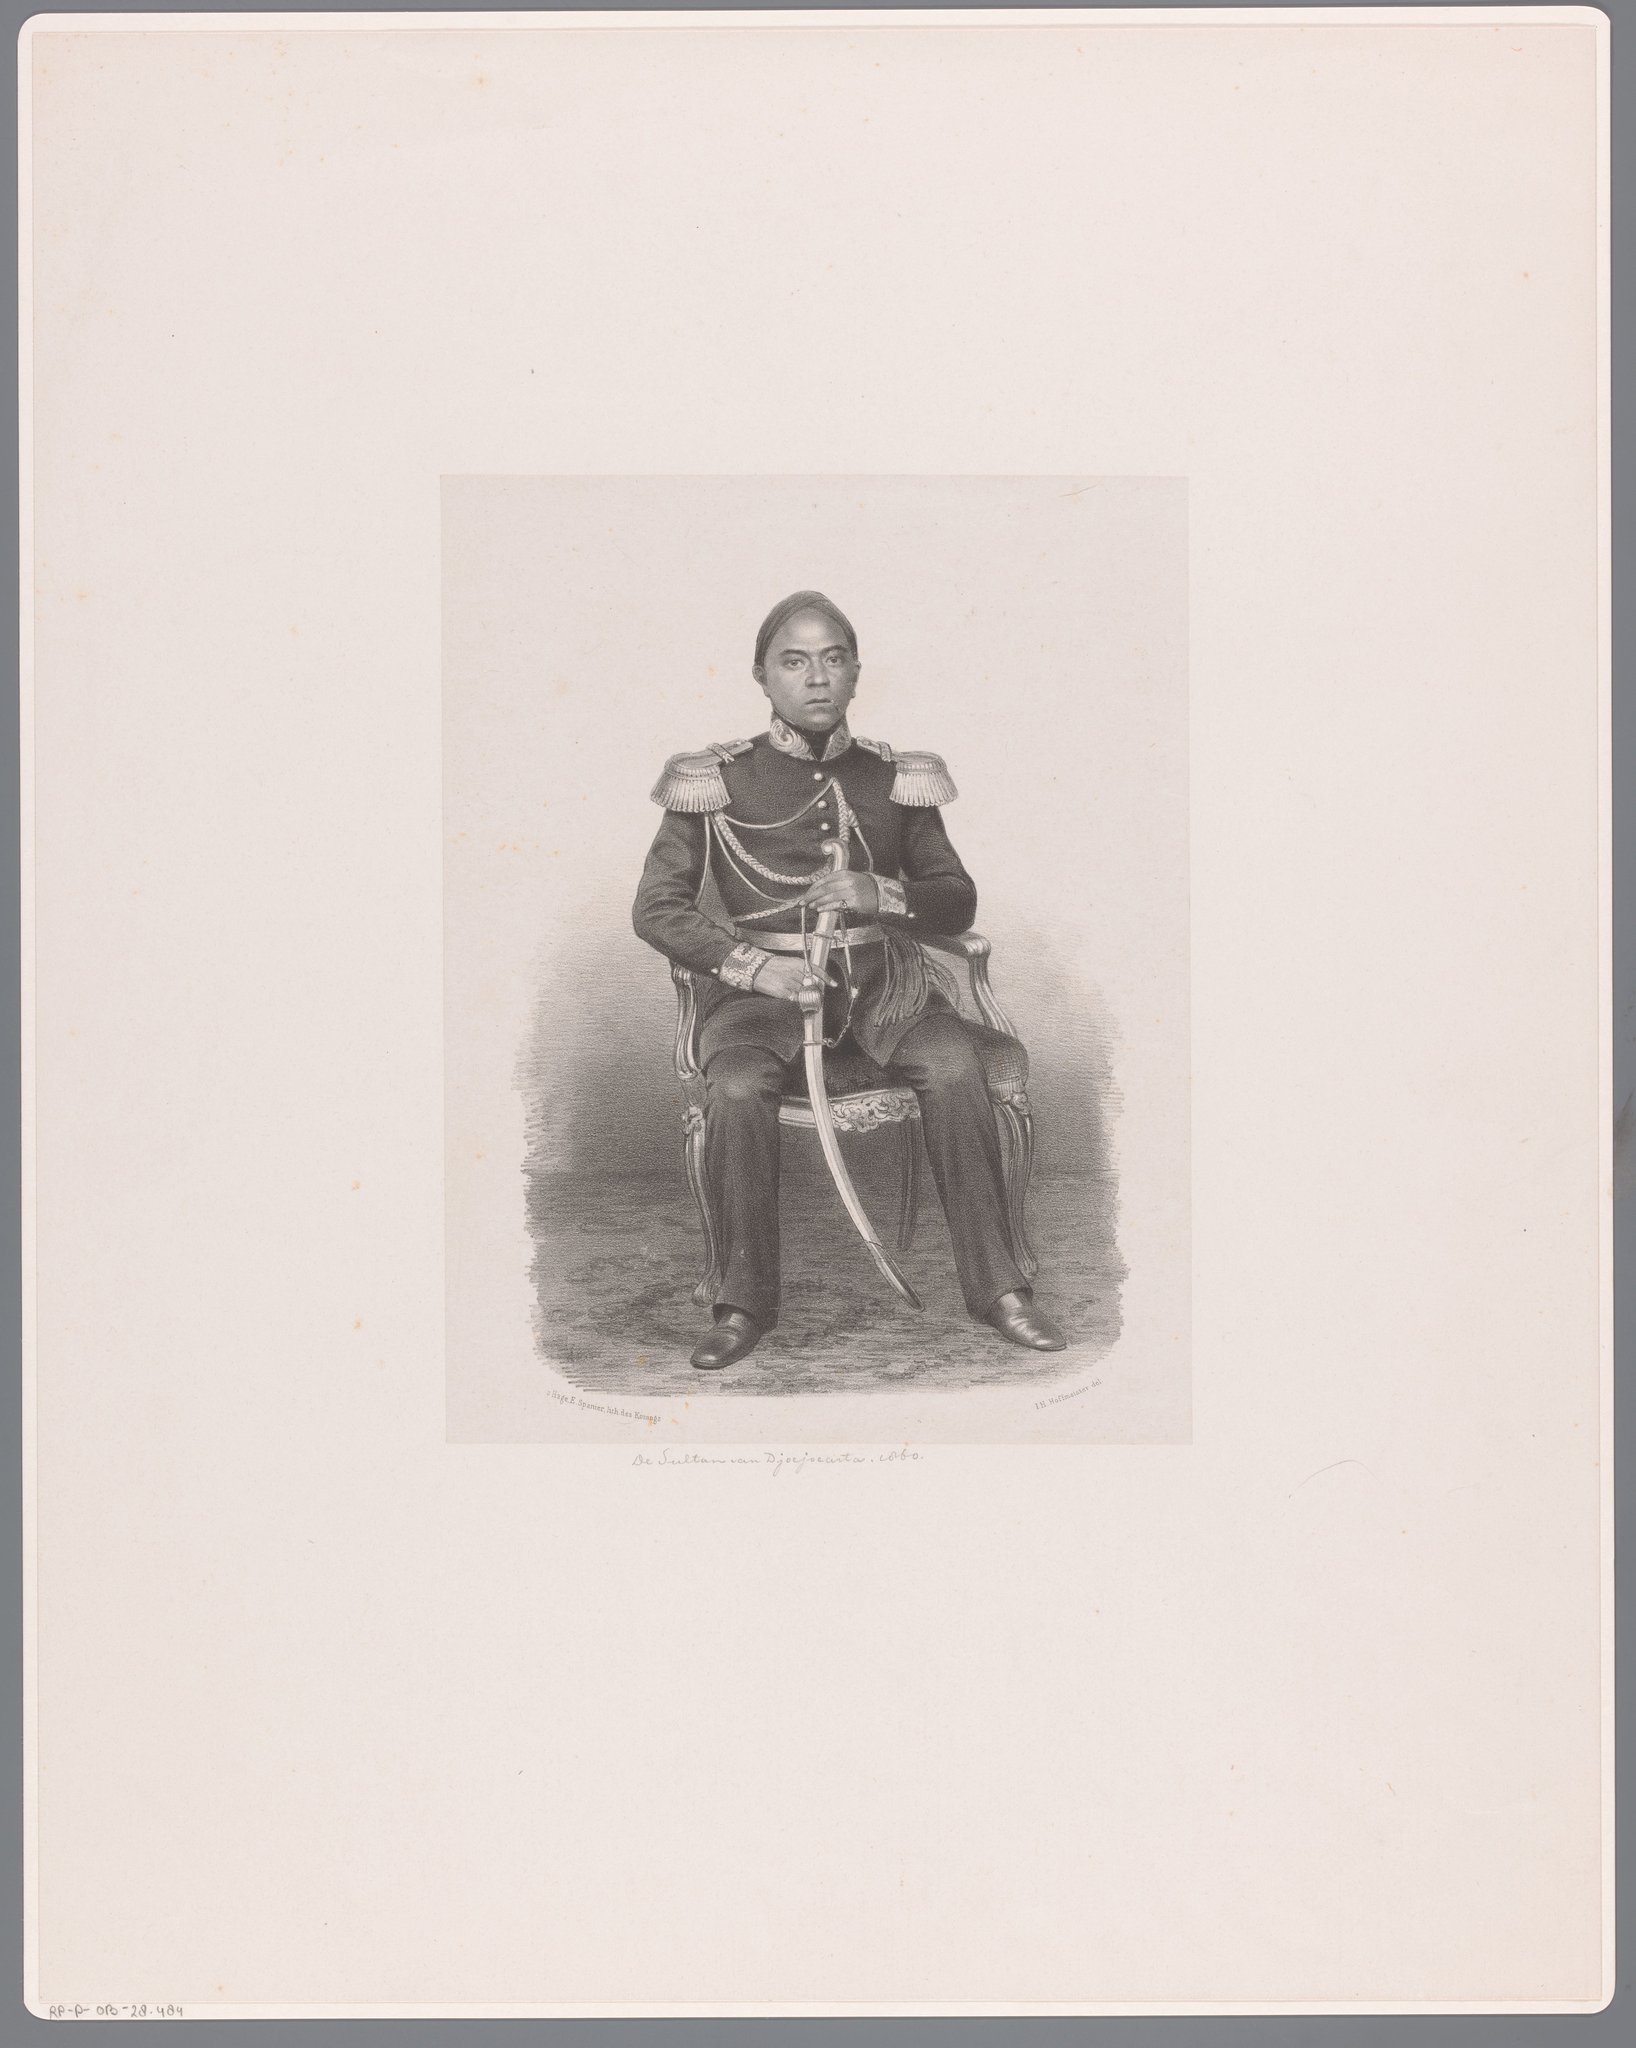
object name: print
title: Portret van Hamangkoe Boewono VI, de sultan van Jogyakarta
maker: johan hendrik hoffmeister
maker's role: print maker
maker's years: 1823-1904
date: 1860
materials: paper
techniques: lithograph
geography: the hague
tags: hacking and thrusting weapons (with name), historical persons (+ full length portrait)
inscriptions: collector's mark: Lugt 2228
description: De geportretteerde zit op een stoel en heeft een sabel of klewang in zijn handen.